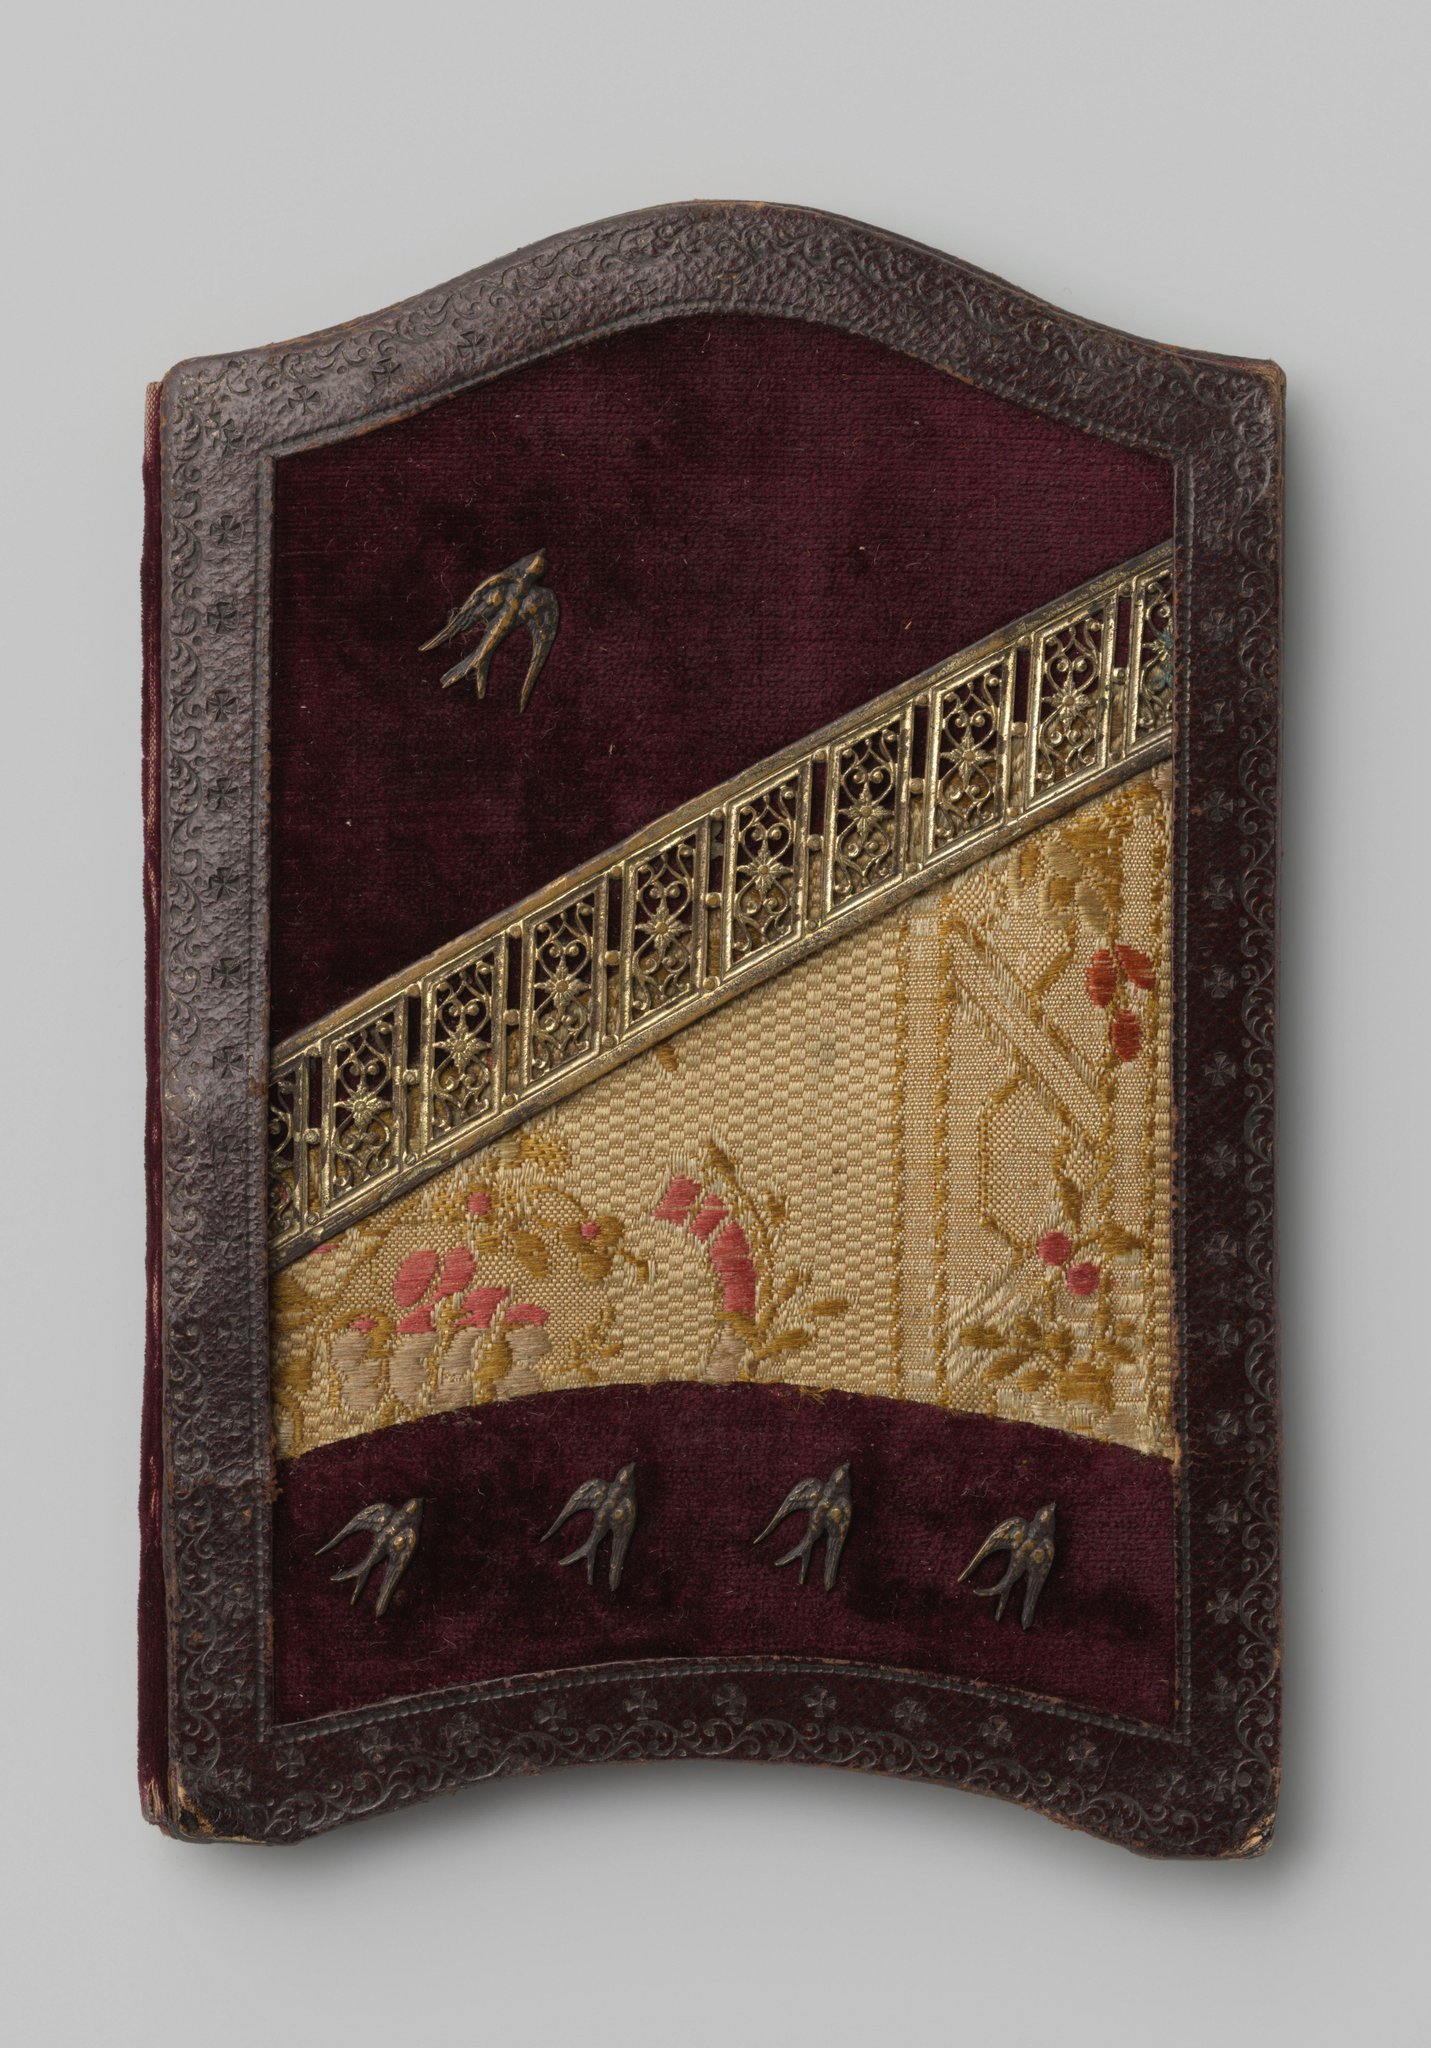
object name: photograph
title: Twee portretten van een onbekende militair en twee onbekende meisjes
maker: Anonymous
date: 1880-1900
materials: cardboard, leather, metal, paper, textile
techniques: albumen print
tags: girl (child between toddler and youth), the soldier; the soldier's life